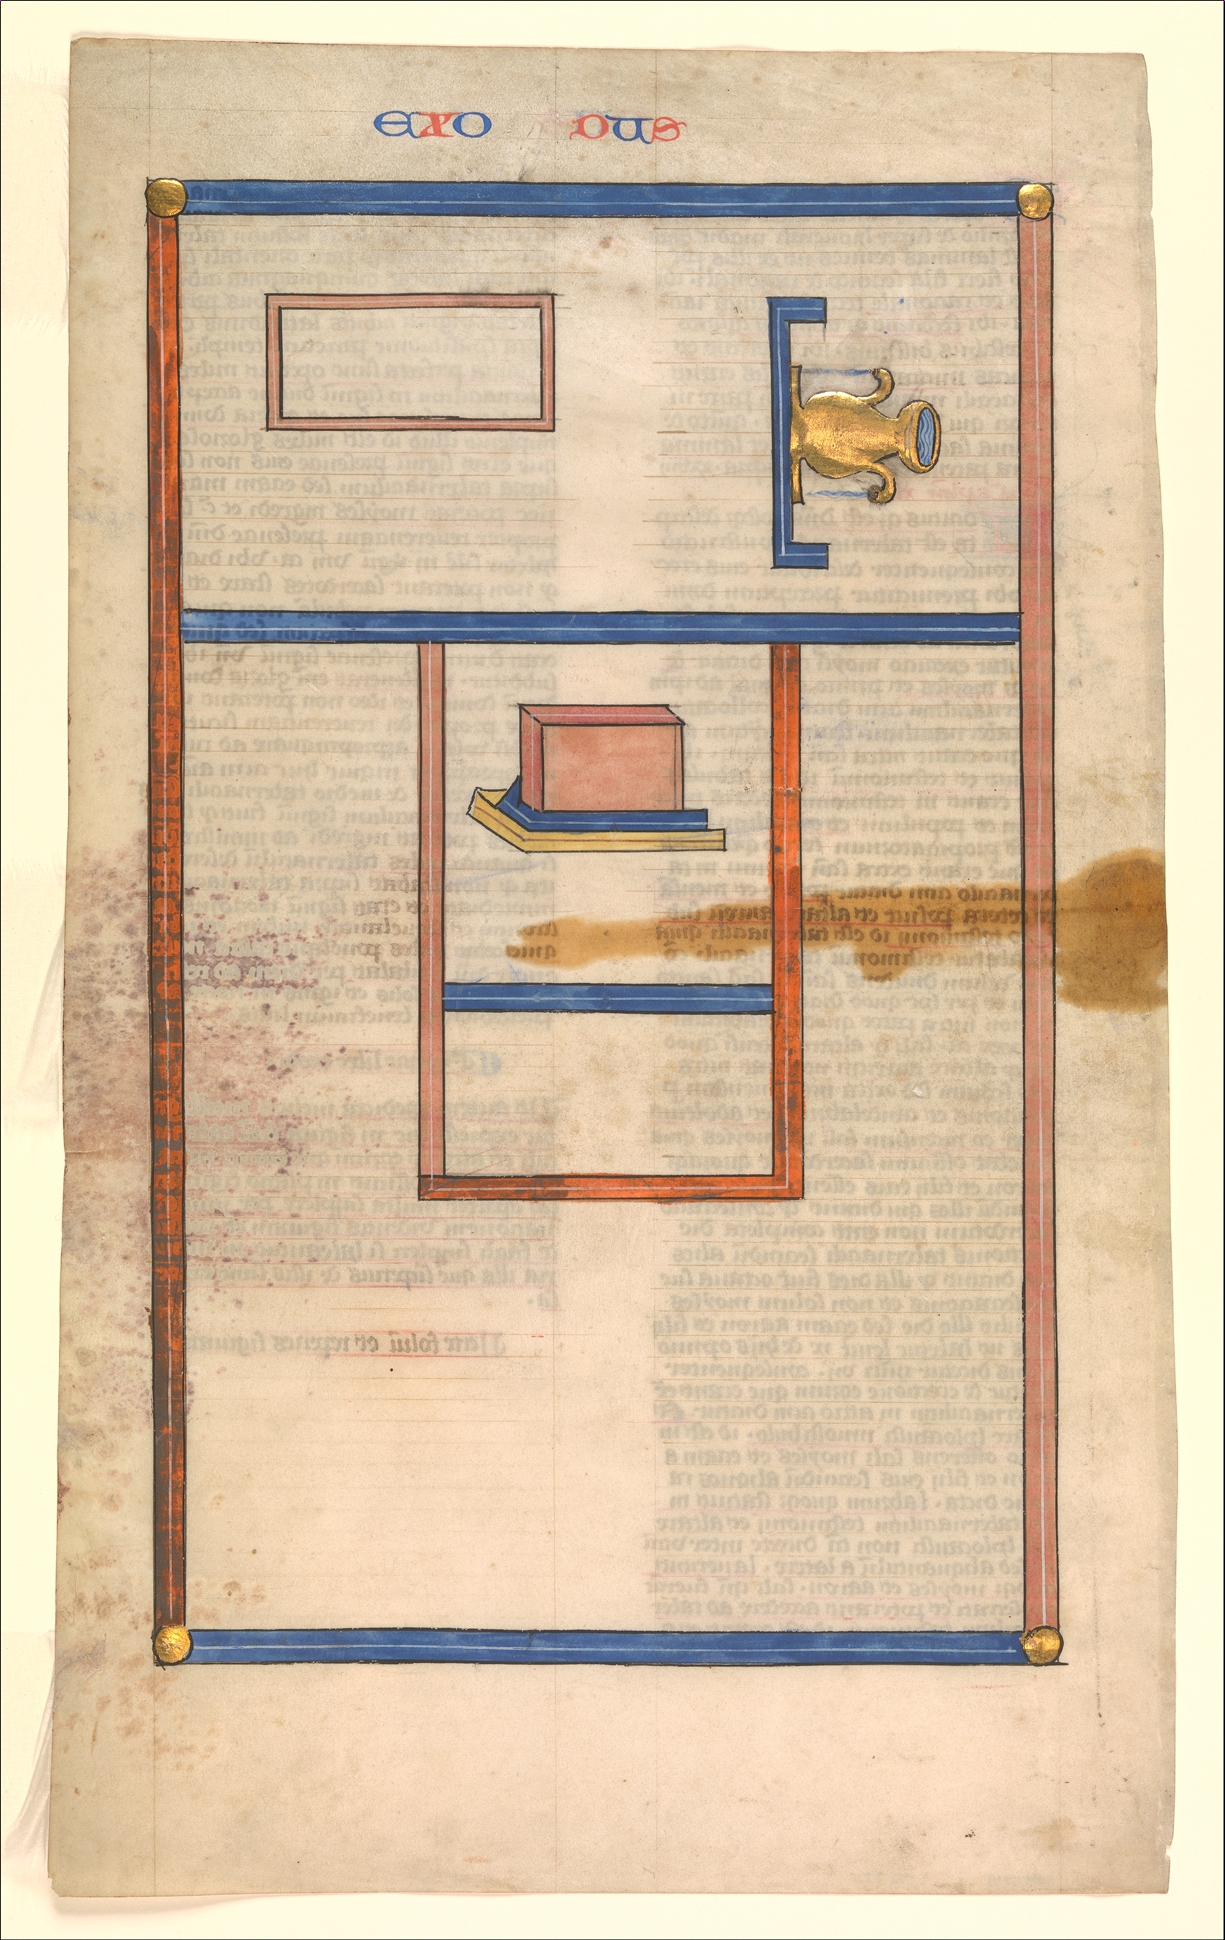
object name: manuscript leaf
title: Floor Plan of the Tabernacle, one of six illustrated leaves from the Postilla Litteralis (Literal Commentary) of Nicholas of Lyra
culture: french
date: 1360-1380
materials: gold, ink, iron, parchment, watercolor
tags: architecture